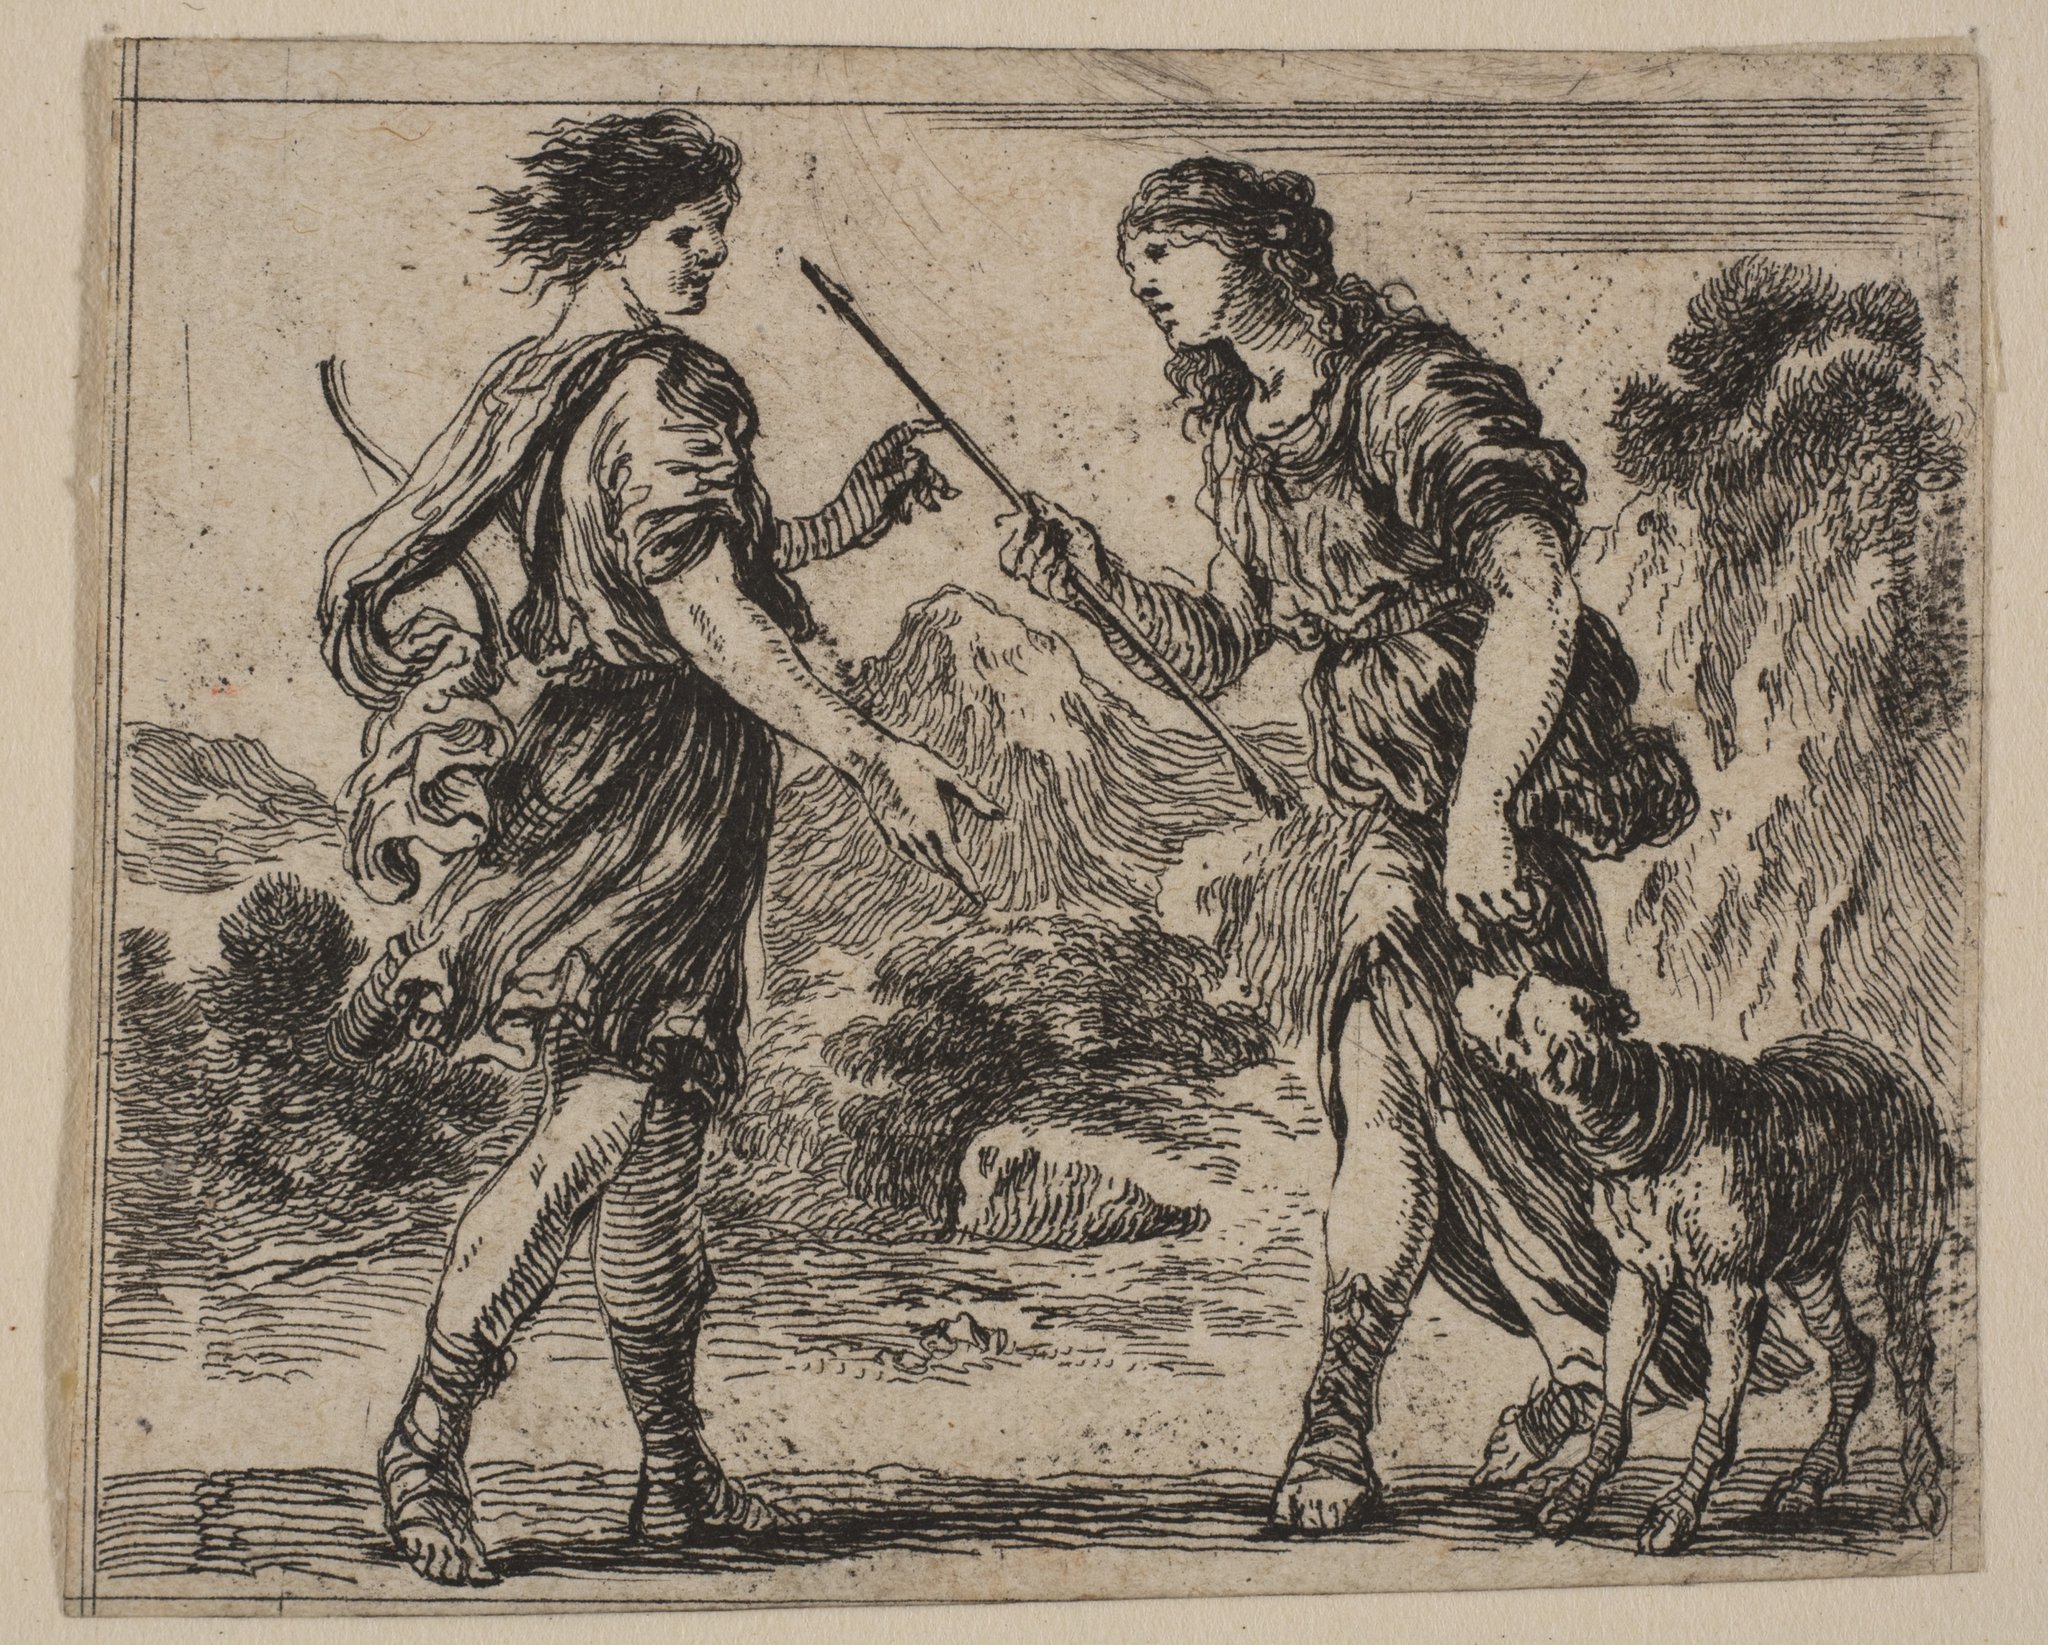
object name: print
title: Cephalus and Procris, from 'Game of Mythology' (Jeu de la Mythologie)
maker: stefano della bella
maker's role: artist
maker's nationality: italian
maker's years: 1610-1664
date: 1644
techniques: etching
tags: men,dogs